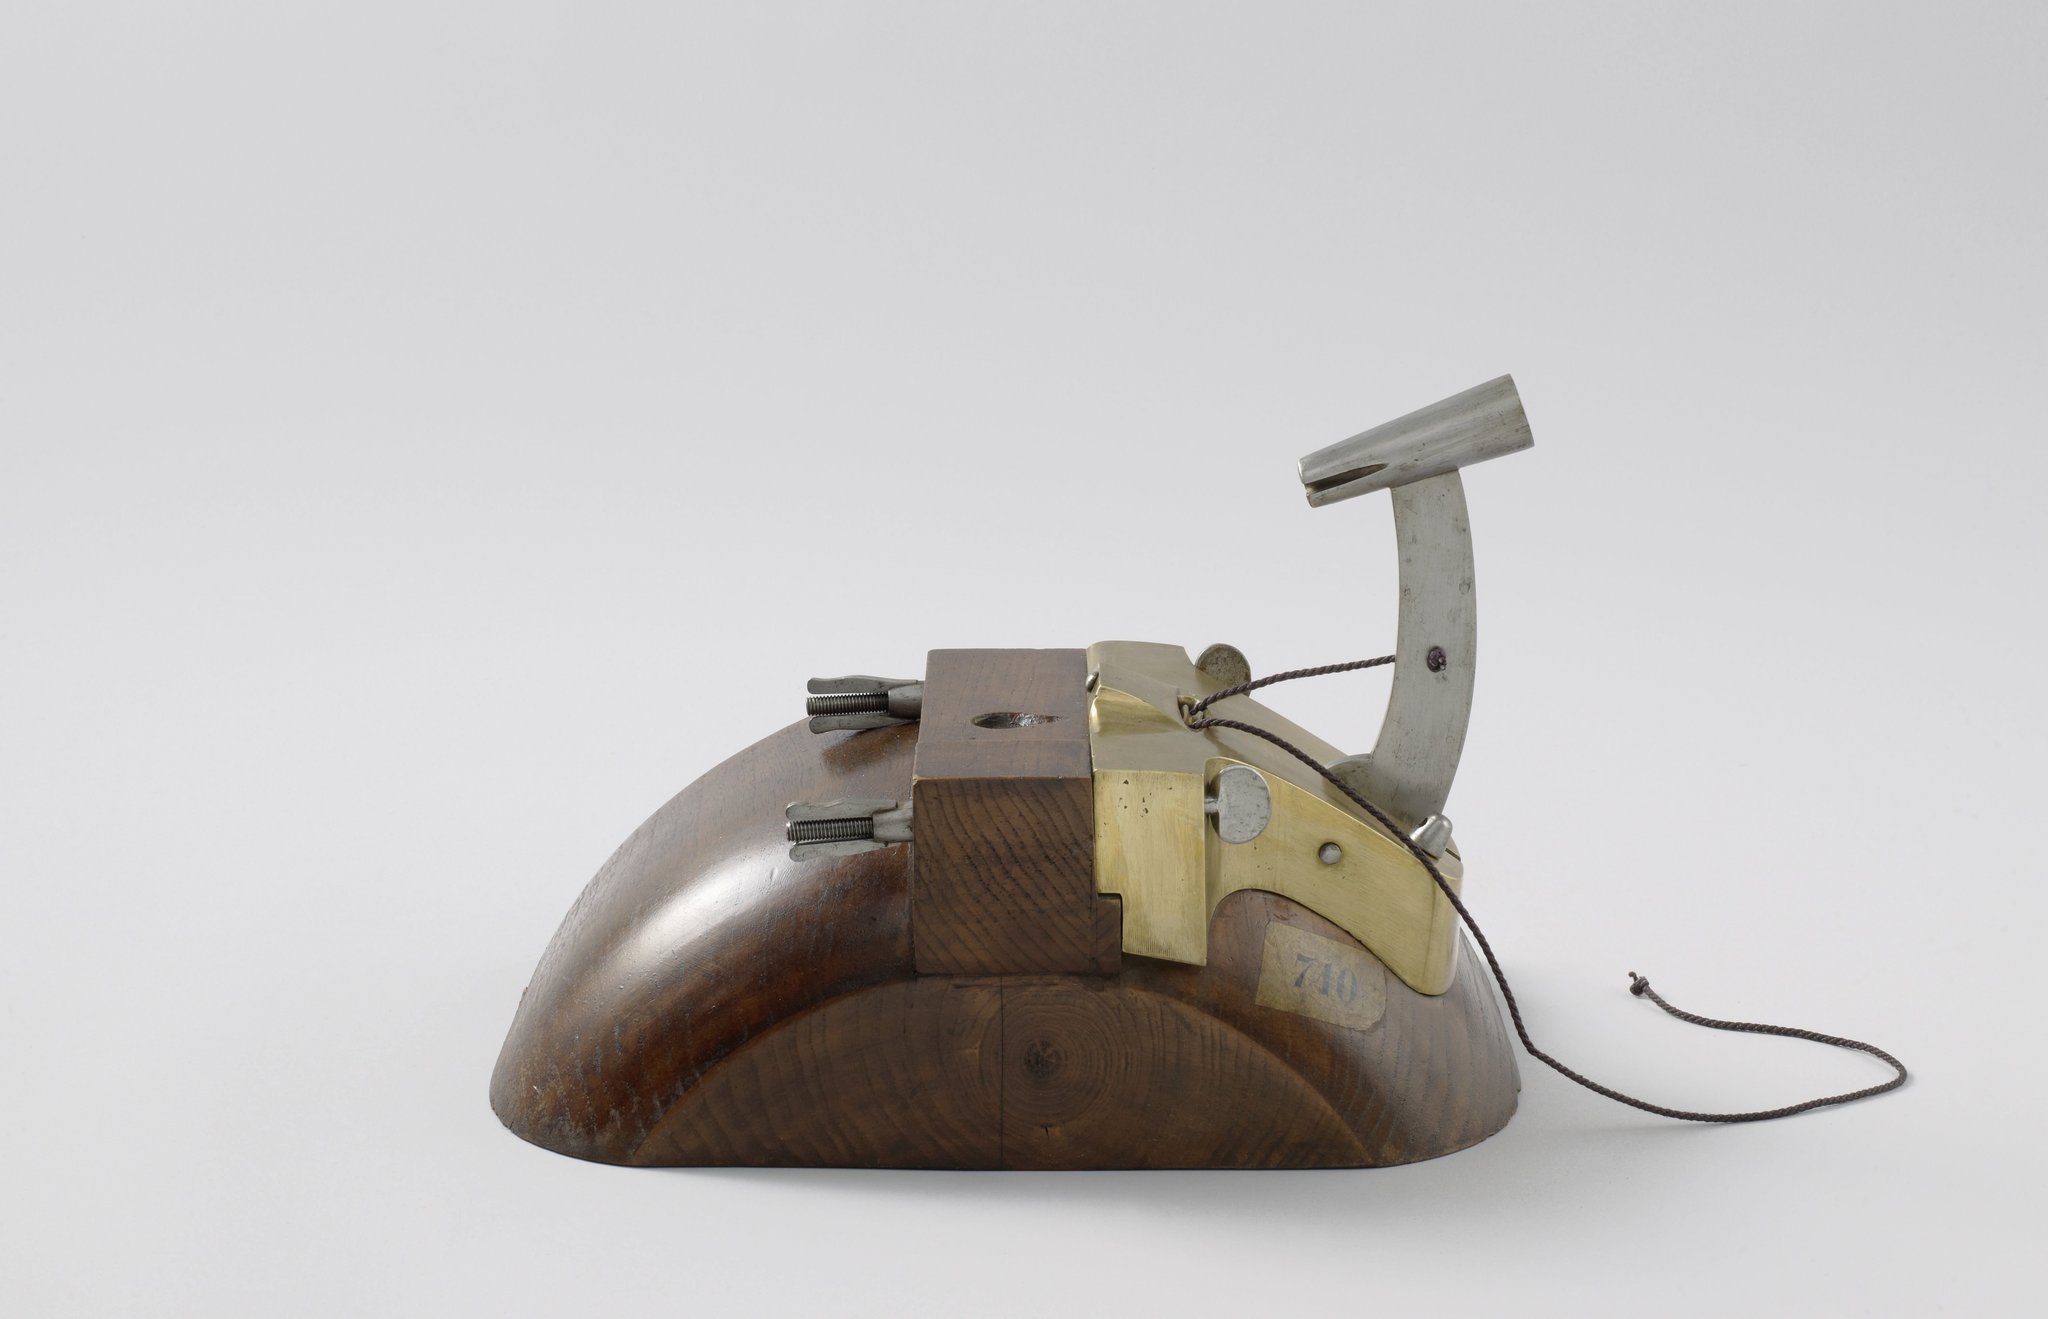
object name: percussion lock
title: Gunlock (Percussion) on a Dummy Breech of a 30-Pounder Carronade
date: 1836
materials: brass, iron, wood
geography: amsterdam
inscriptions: label, on the front: ‘710’ former inventory label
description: Percussieslot op houten kulas van een carronade van 30 pond. De zware slotplaat is aan de rechterzijde tegen de slotverhevenheid gemonteerd met twee bouten er dwars doorheen, en twee schroeven in het kulas. De hamer draait in een rechte hoek ten opzichte van de loop. De kop van de hamer heeft een gleuf voor de vlam uit het zundgat als afgevuurd wordt. In de schacht is een gat voor het aftrektouw aangebracht, in de slotplaat een schijf waardoor het touw naar achteren wordt geleid. Het houten kulas is dat van een carronade van 30 pond.